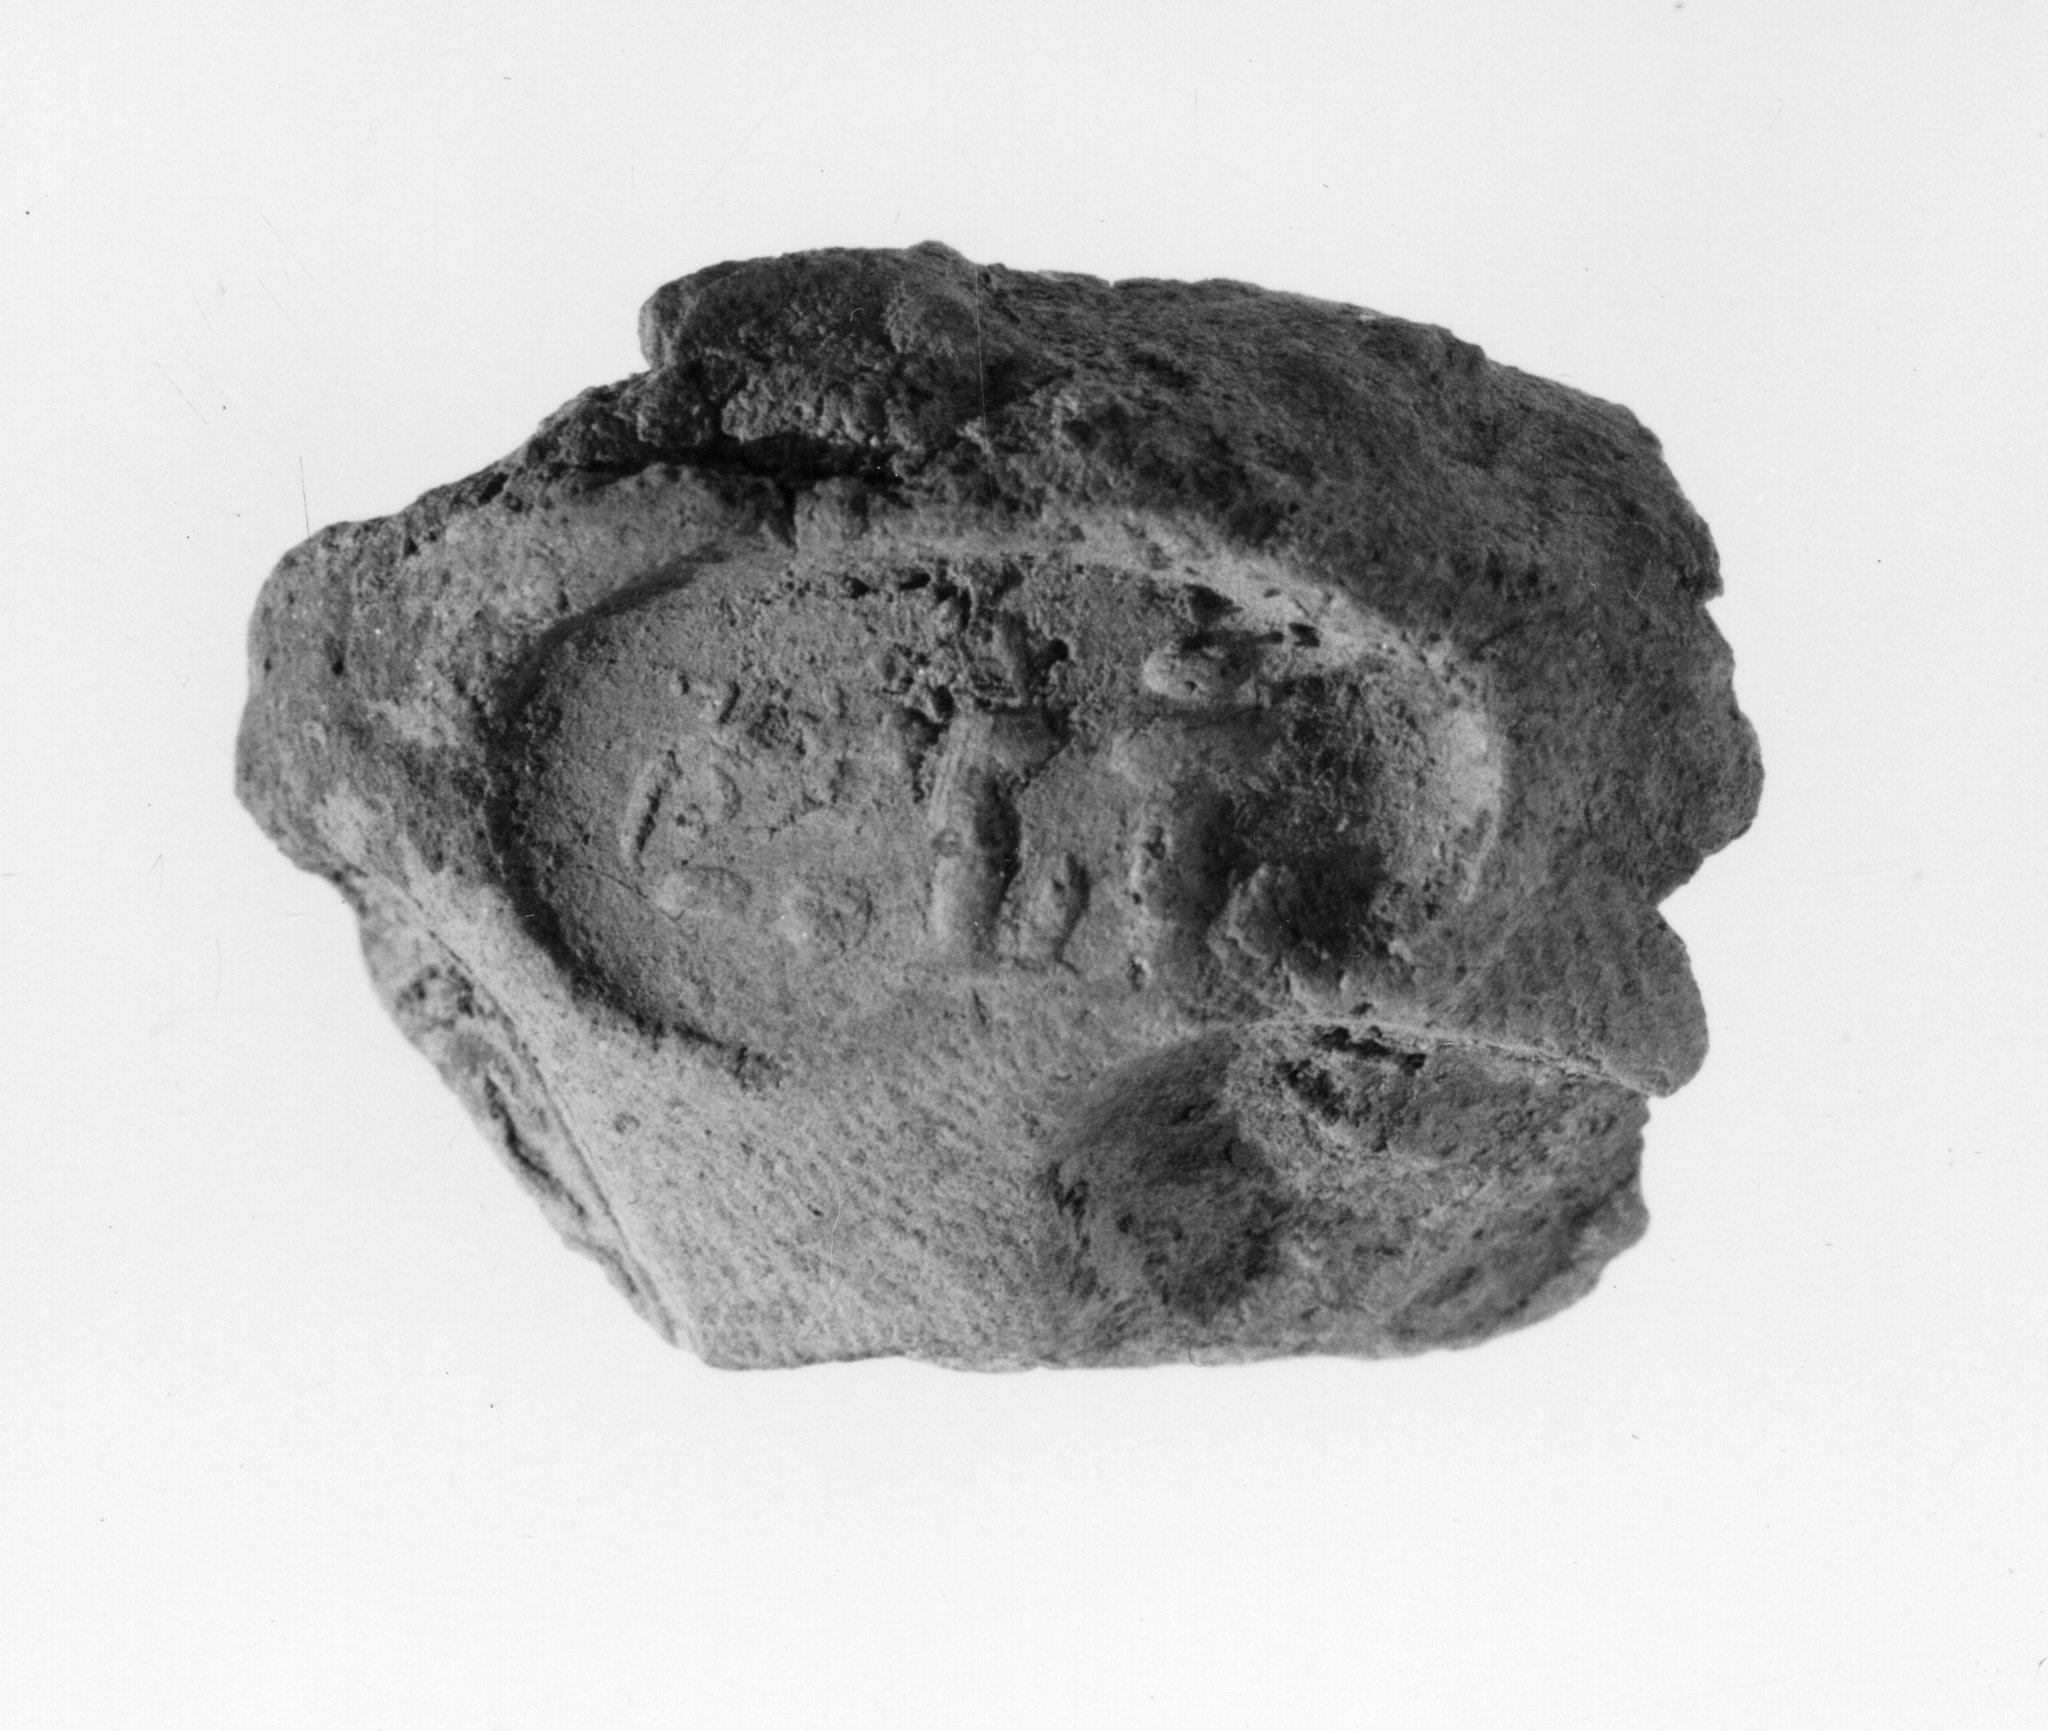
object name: sealing, amenhotep iii, nebmaatre, cobra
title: Document Sealing With Multiple Seal Impressions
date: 1390-1352 BCE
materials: mud